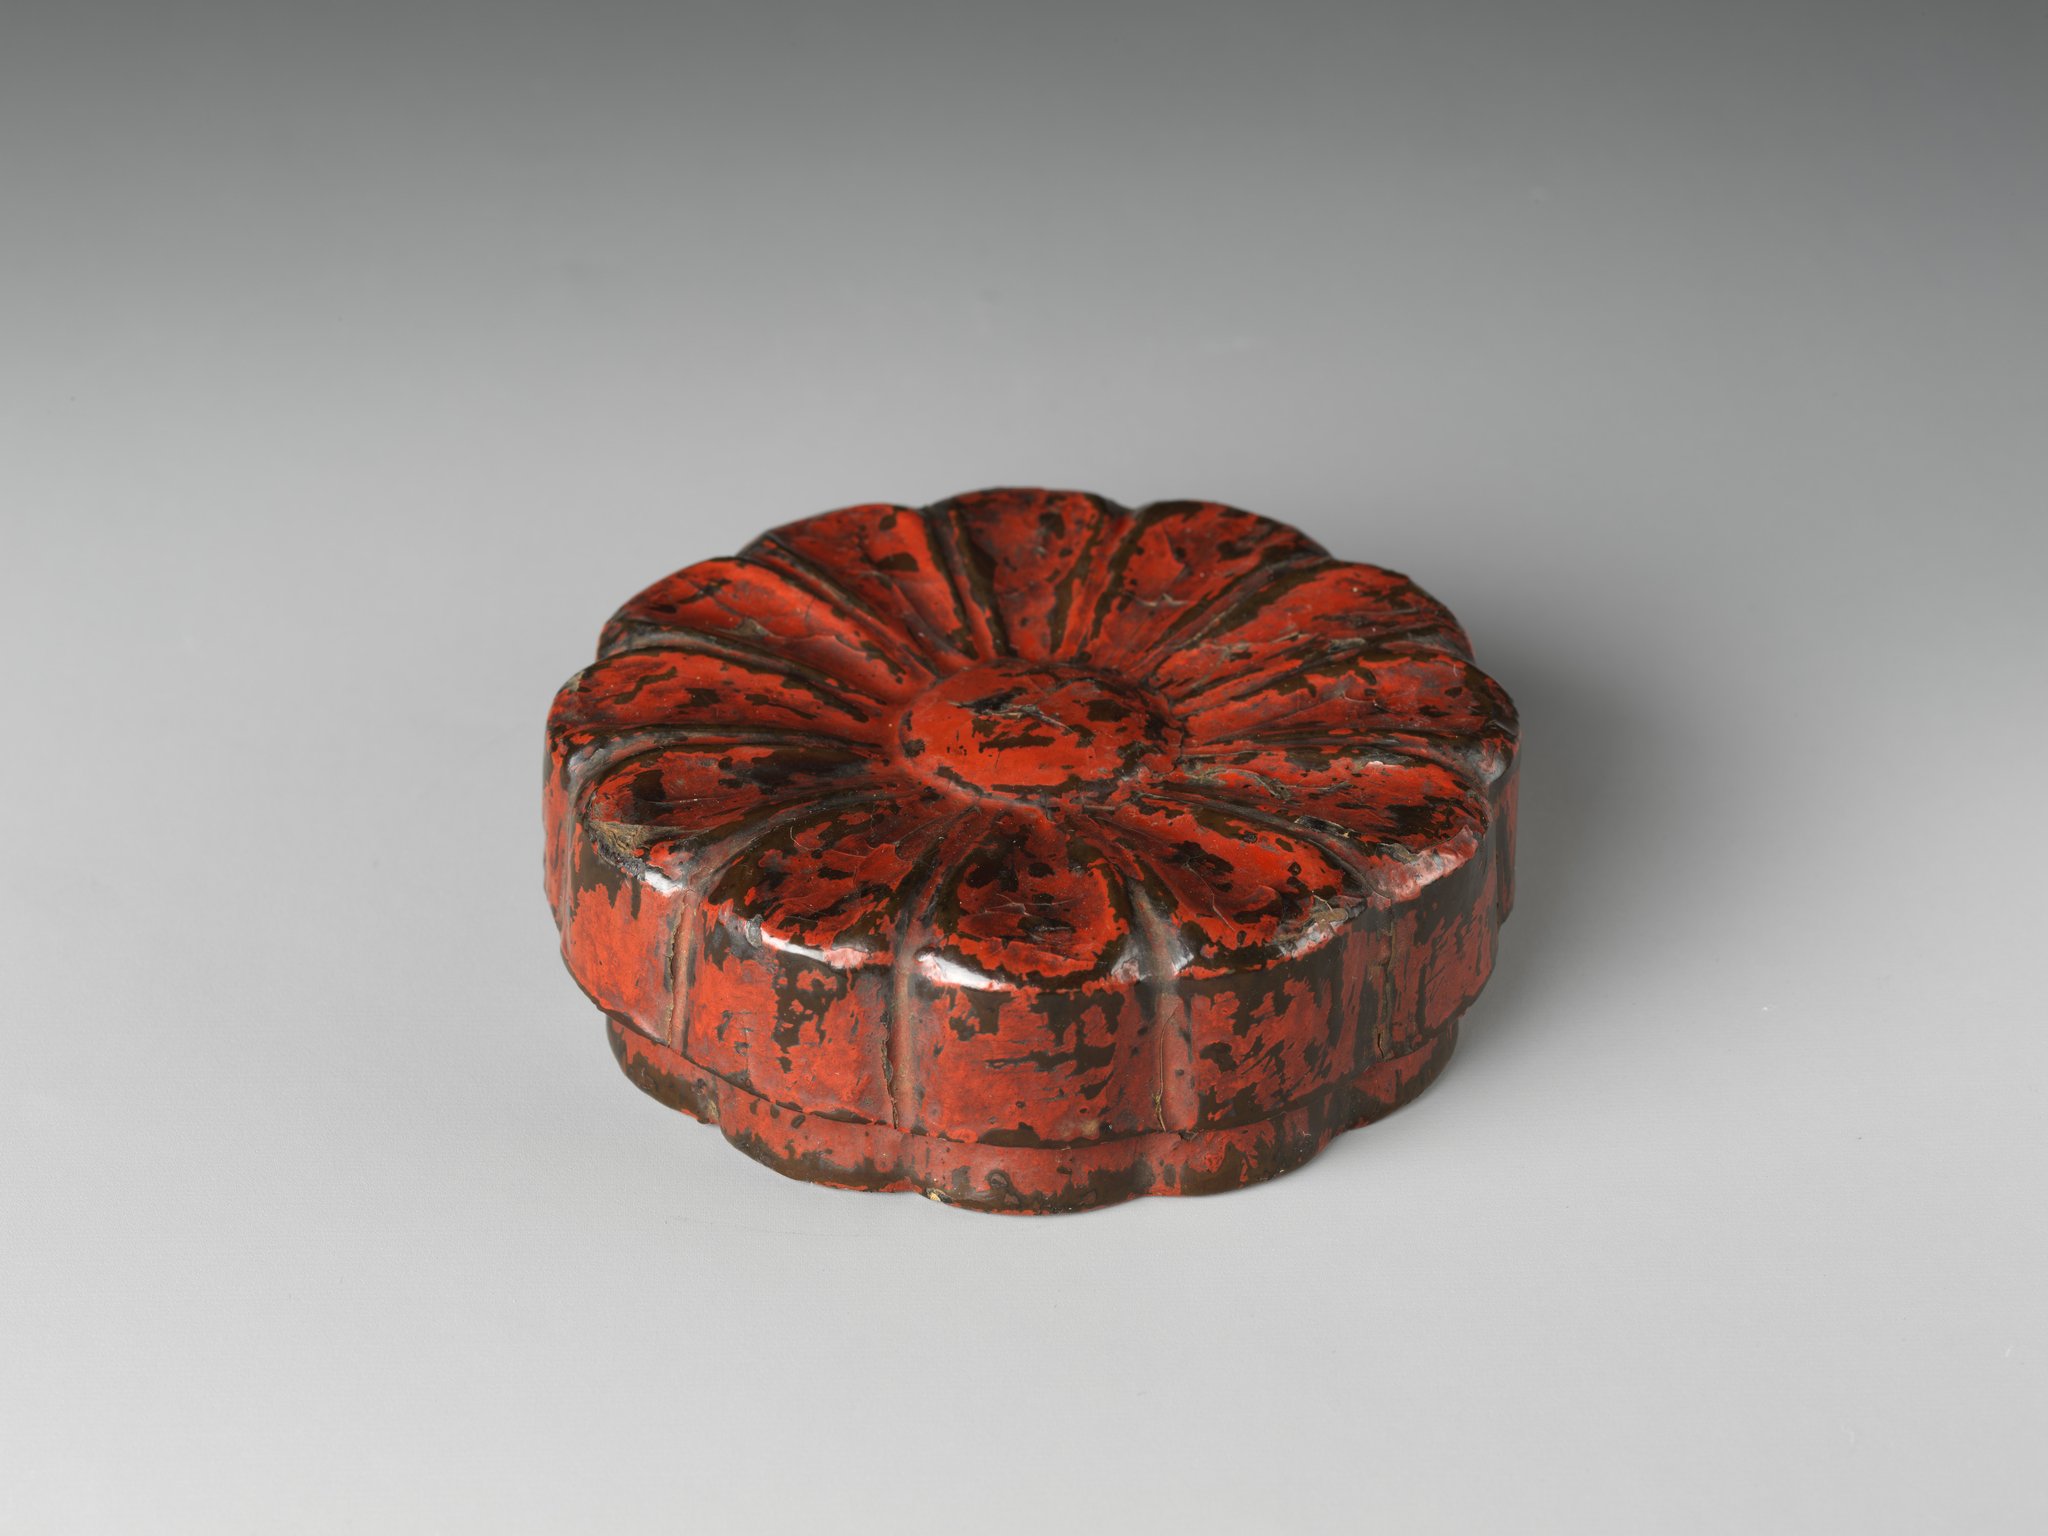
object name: box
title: Incense box in shape of a chrysanthemum blossom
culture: japanese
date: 1615-1867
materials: lacquer